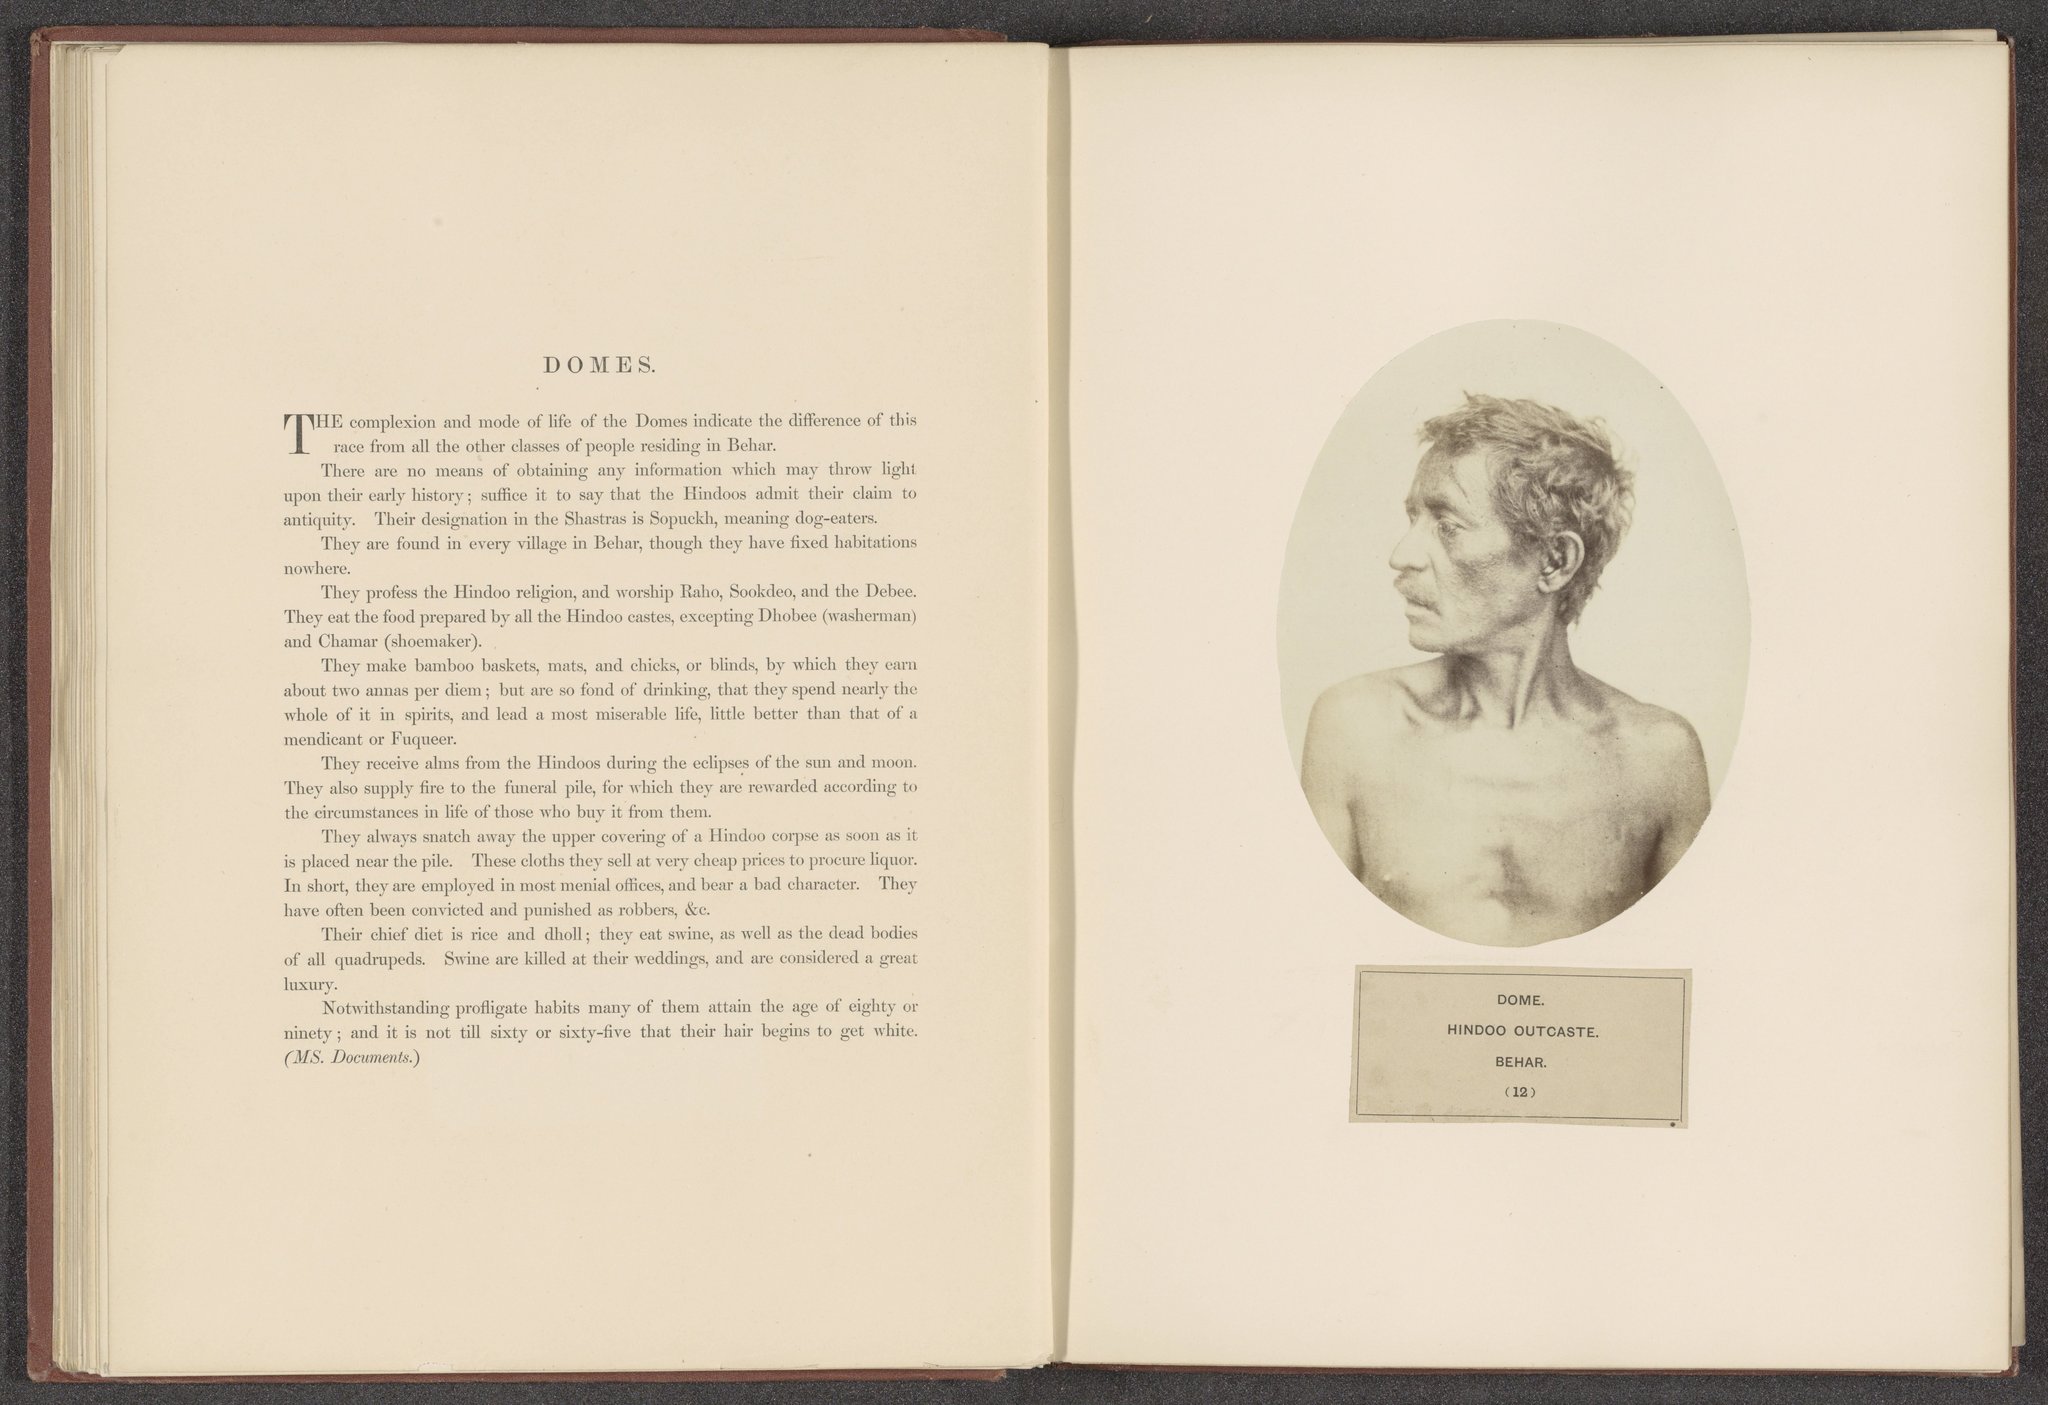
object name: page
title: Portrait of an unknown man from the Dom community of Bihar in eastern India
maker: Anonymous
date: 1858-1868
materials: photographic support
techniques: albumen print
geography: bihar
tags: human races; peoples; nationalities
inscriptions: number: ‘(12)’, inscription: ‘DOME./ HINDOO OUTCASTE./ BEHAR.’